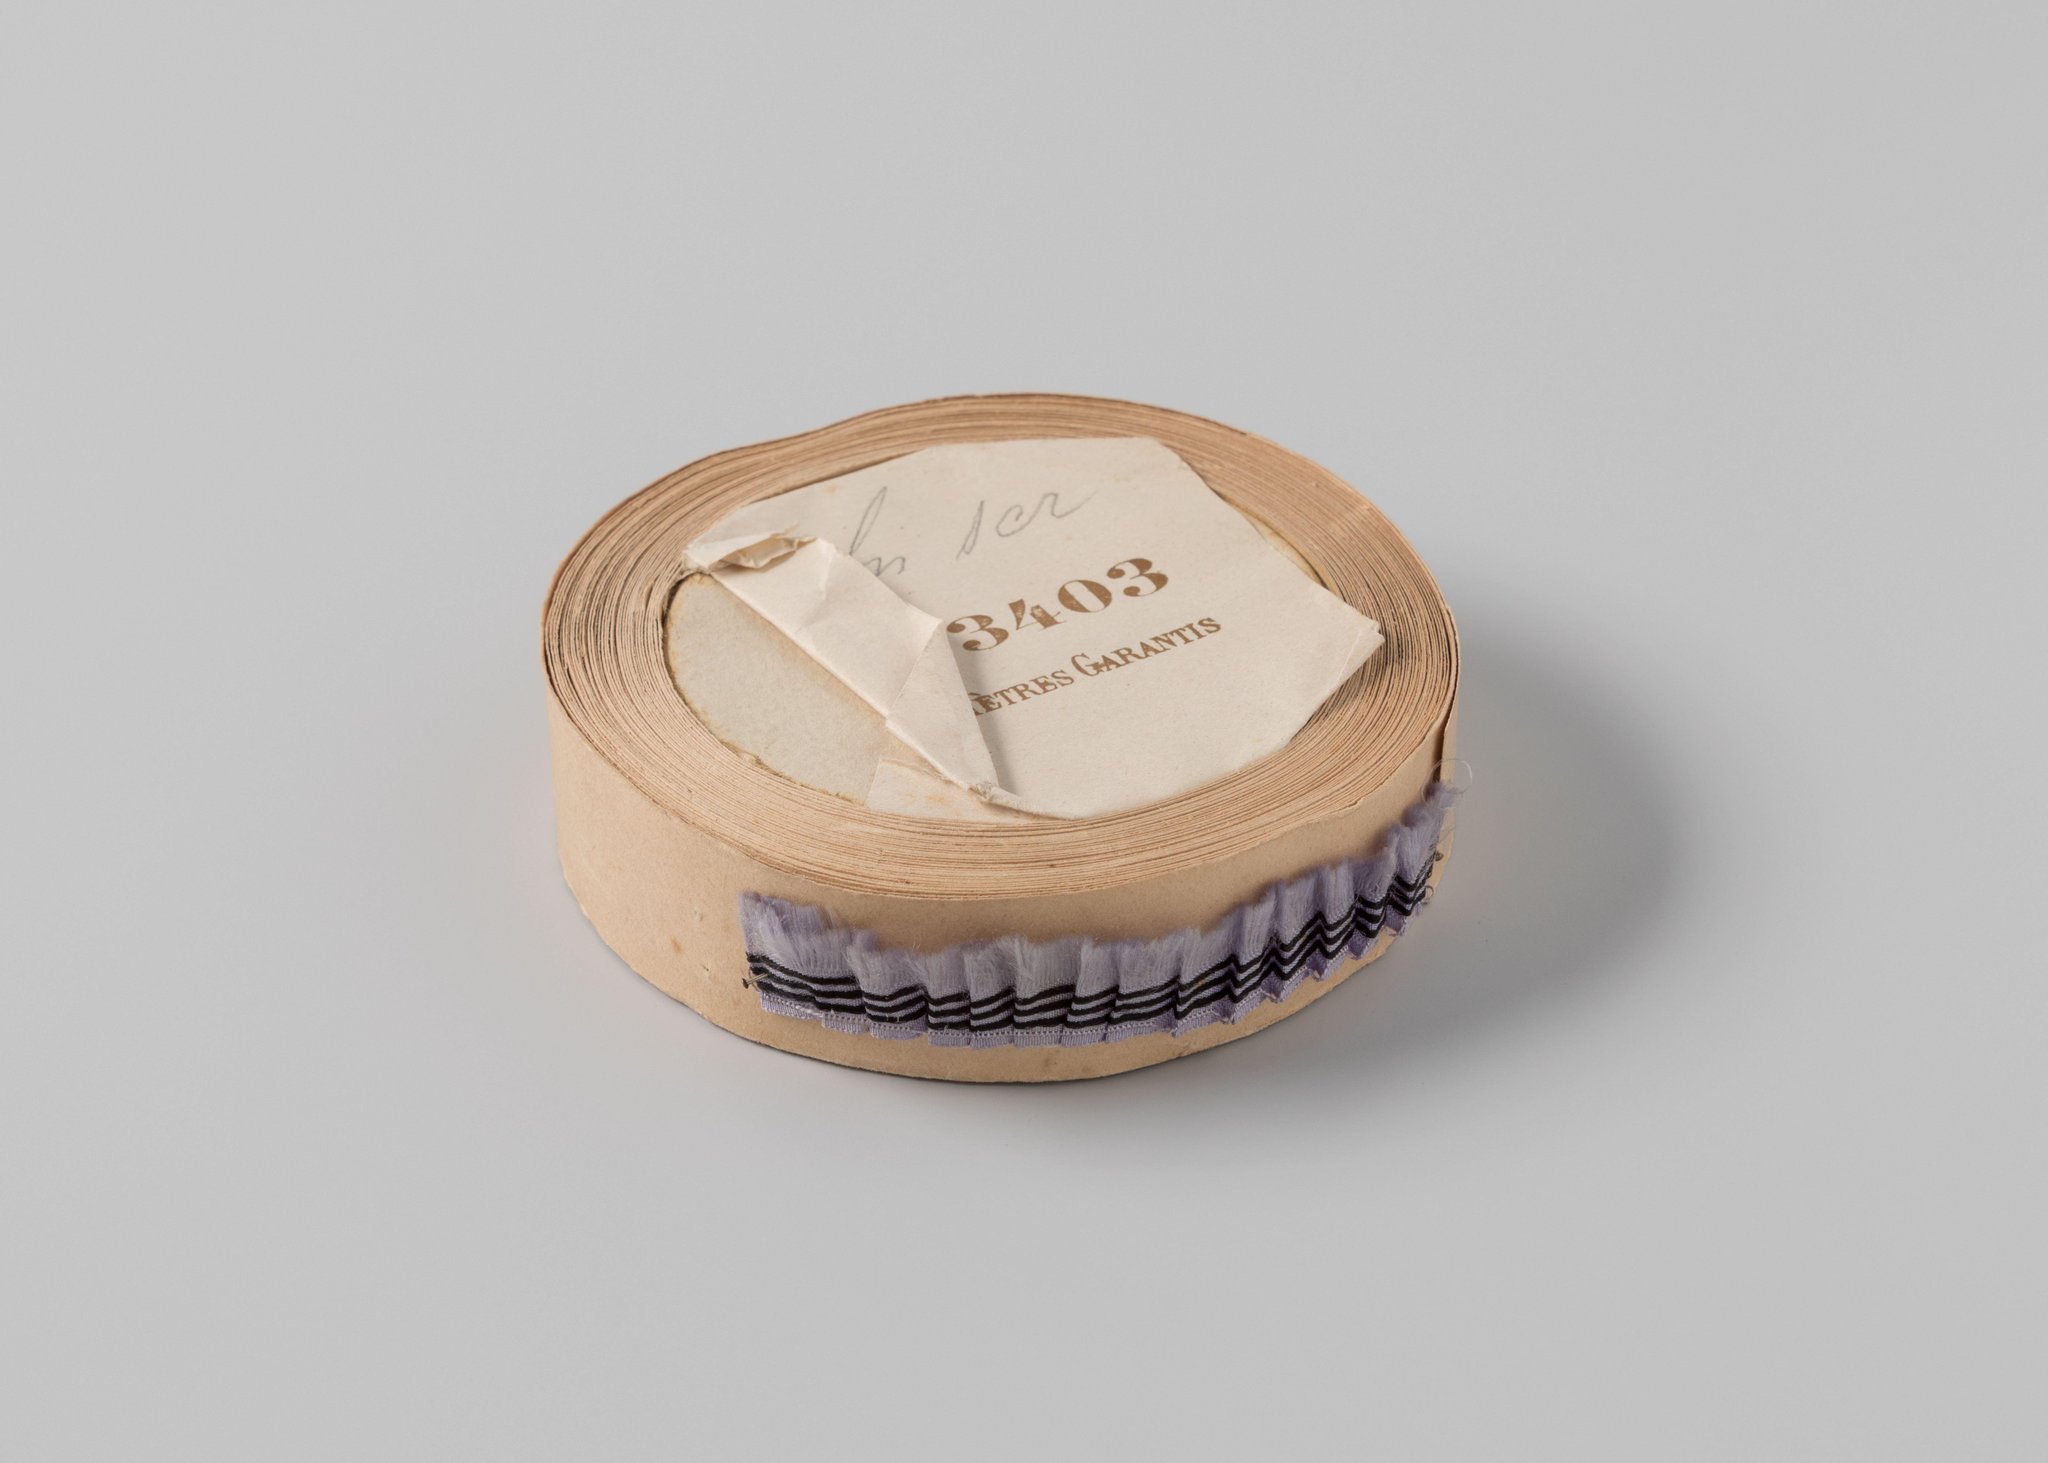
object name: rol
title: Rol met lila lint met één gerafelde zijde en drie zwarte horizontale strepen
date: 1930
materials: cardboard, paper, textile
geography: france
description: Rol met lila lint met één gerafelde zijde en drie zwarte horizontale strepen.